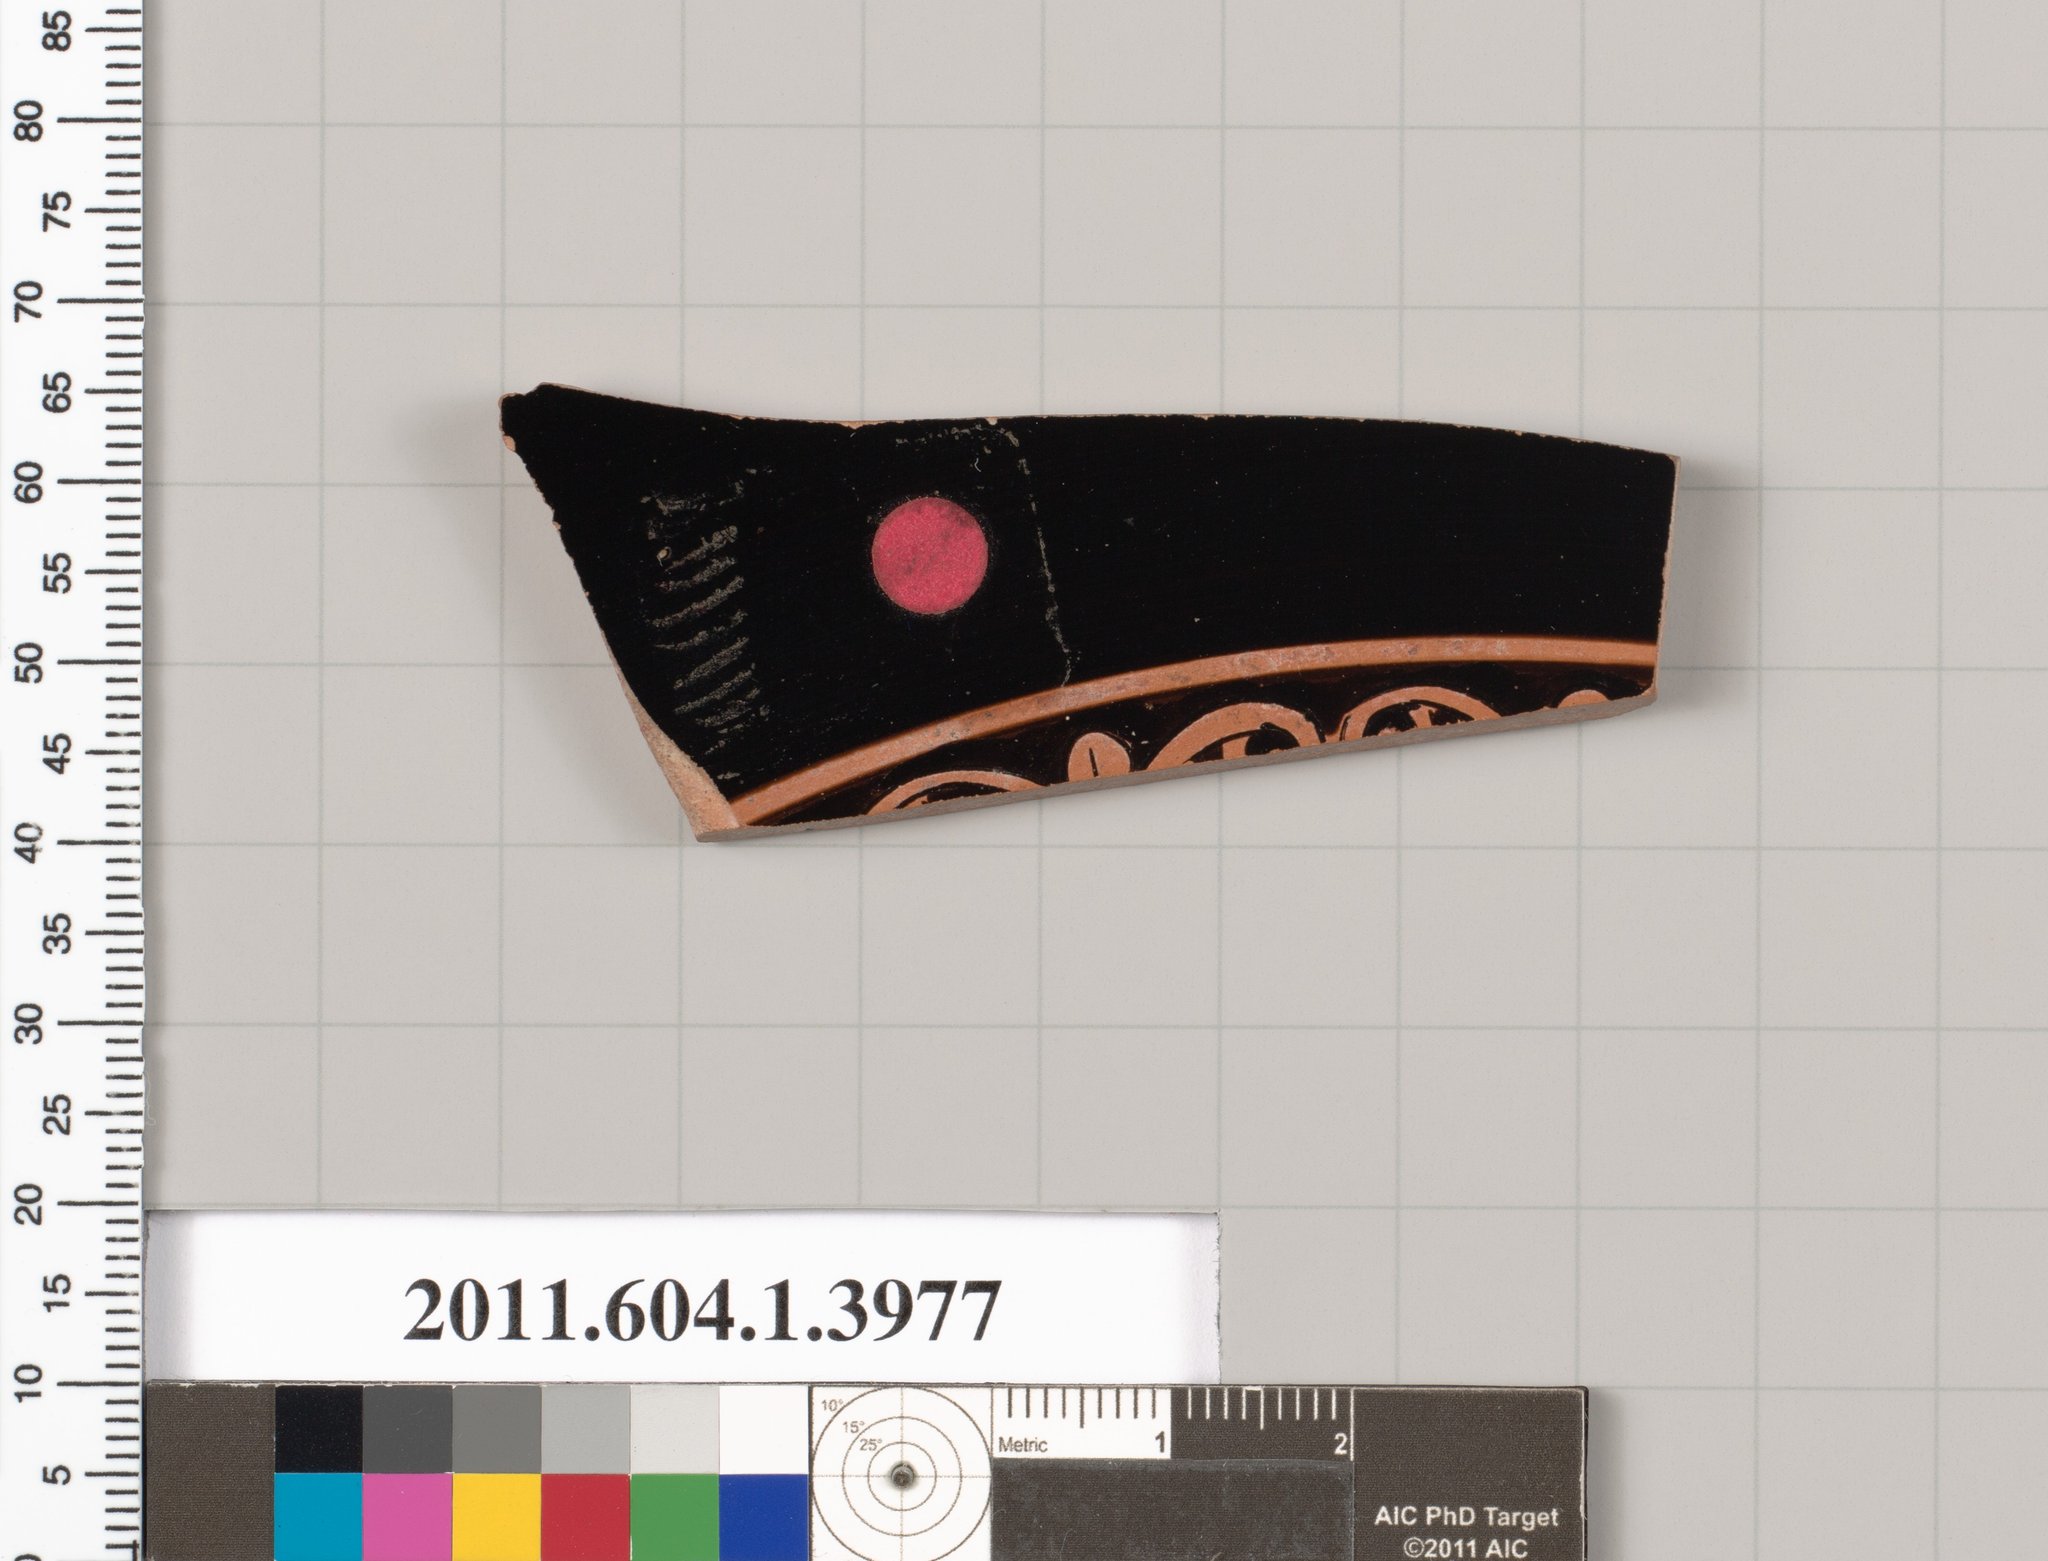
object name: kylix fragment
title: Terracotta fragment of a kylix (drinking cup)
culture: greek, attic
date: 534-468 BCE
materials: terracotta